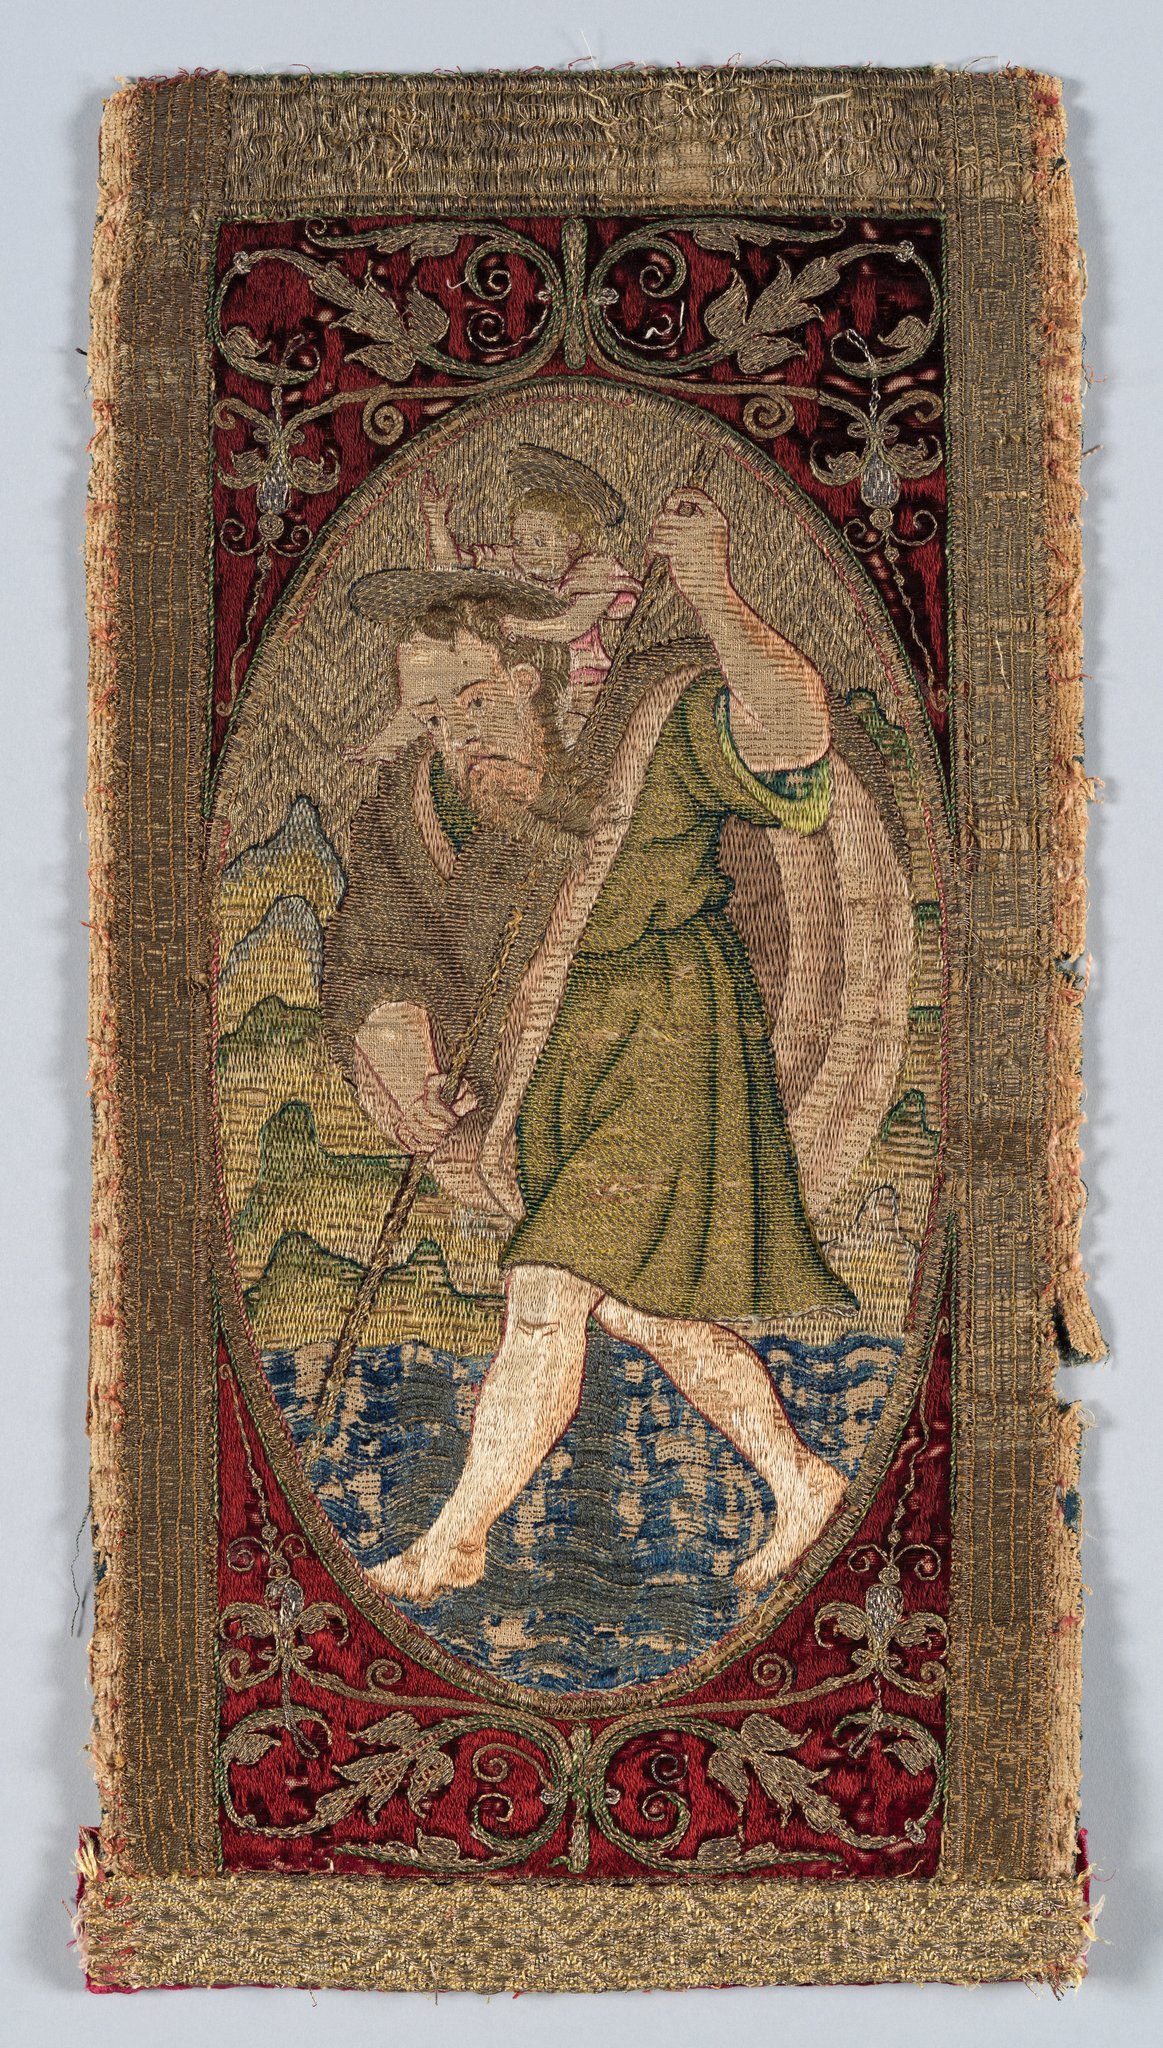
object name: cushion made from orphrey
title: Orphrey section made into cushion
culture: italian or spanish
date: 1551-1600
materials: linen, metal, silk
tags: men